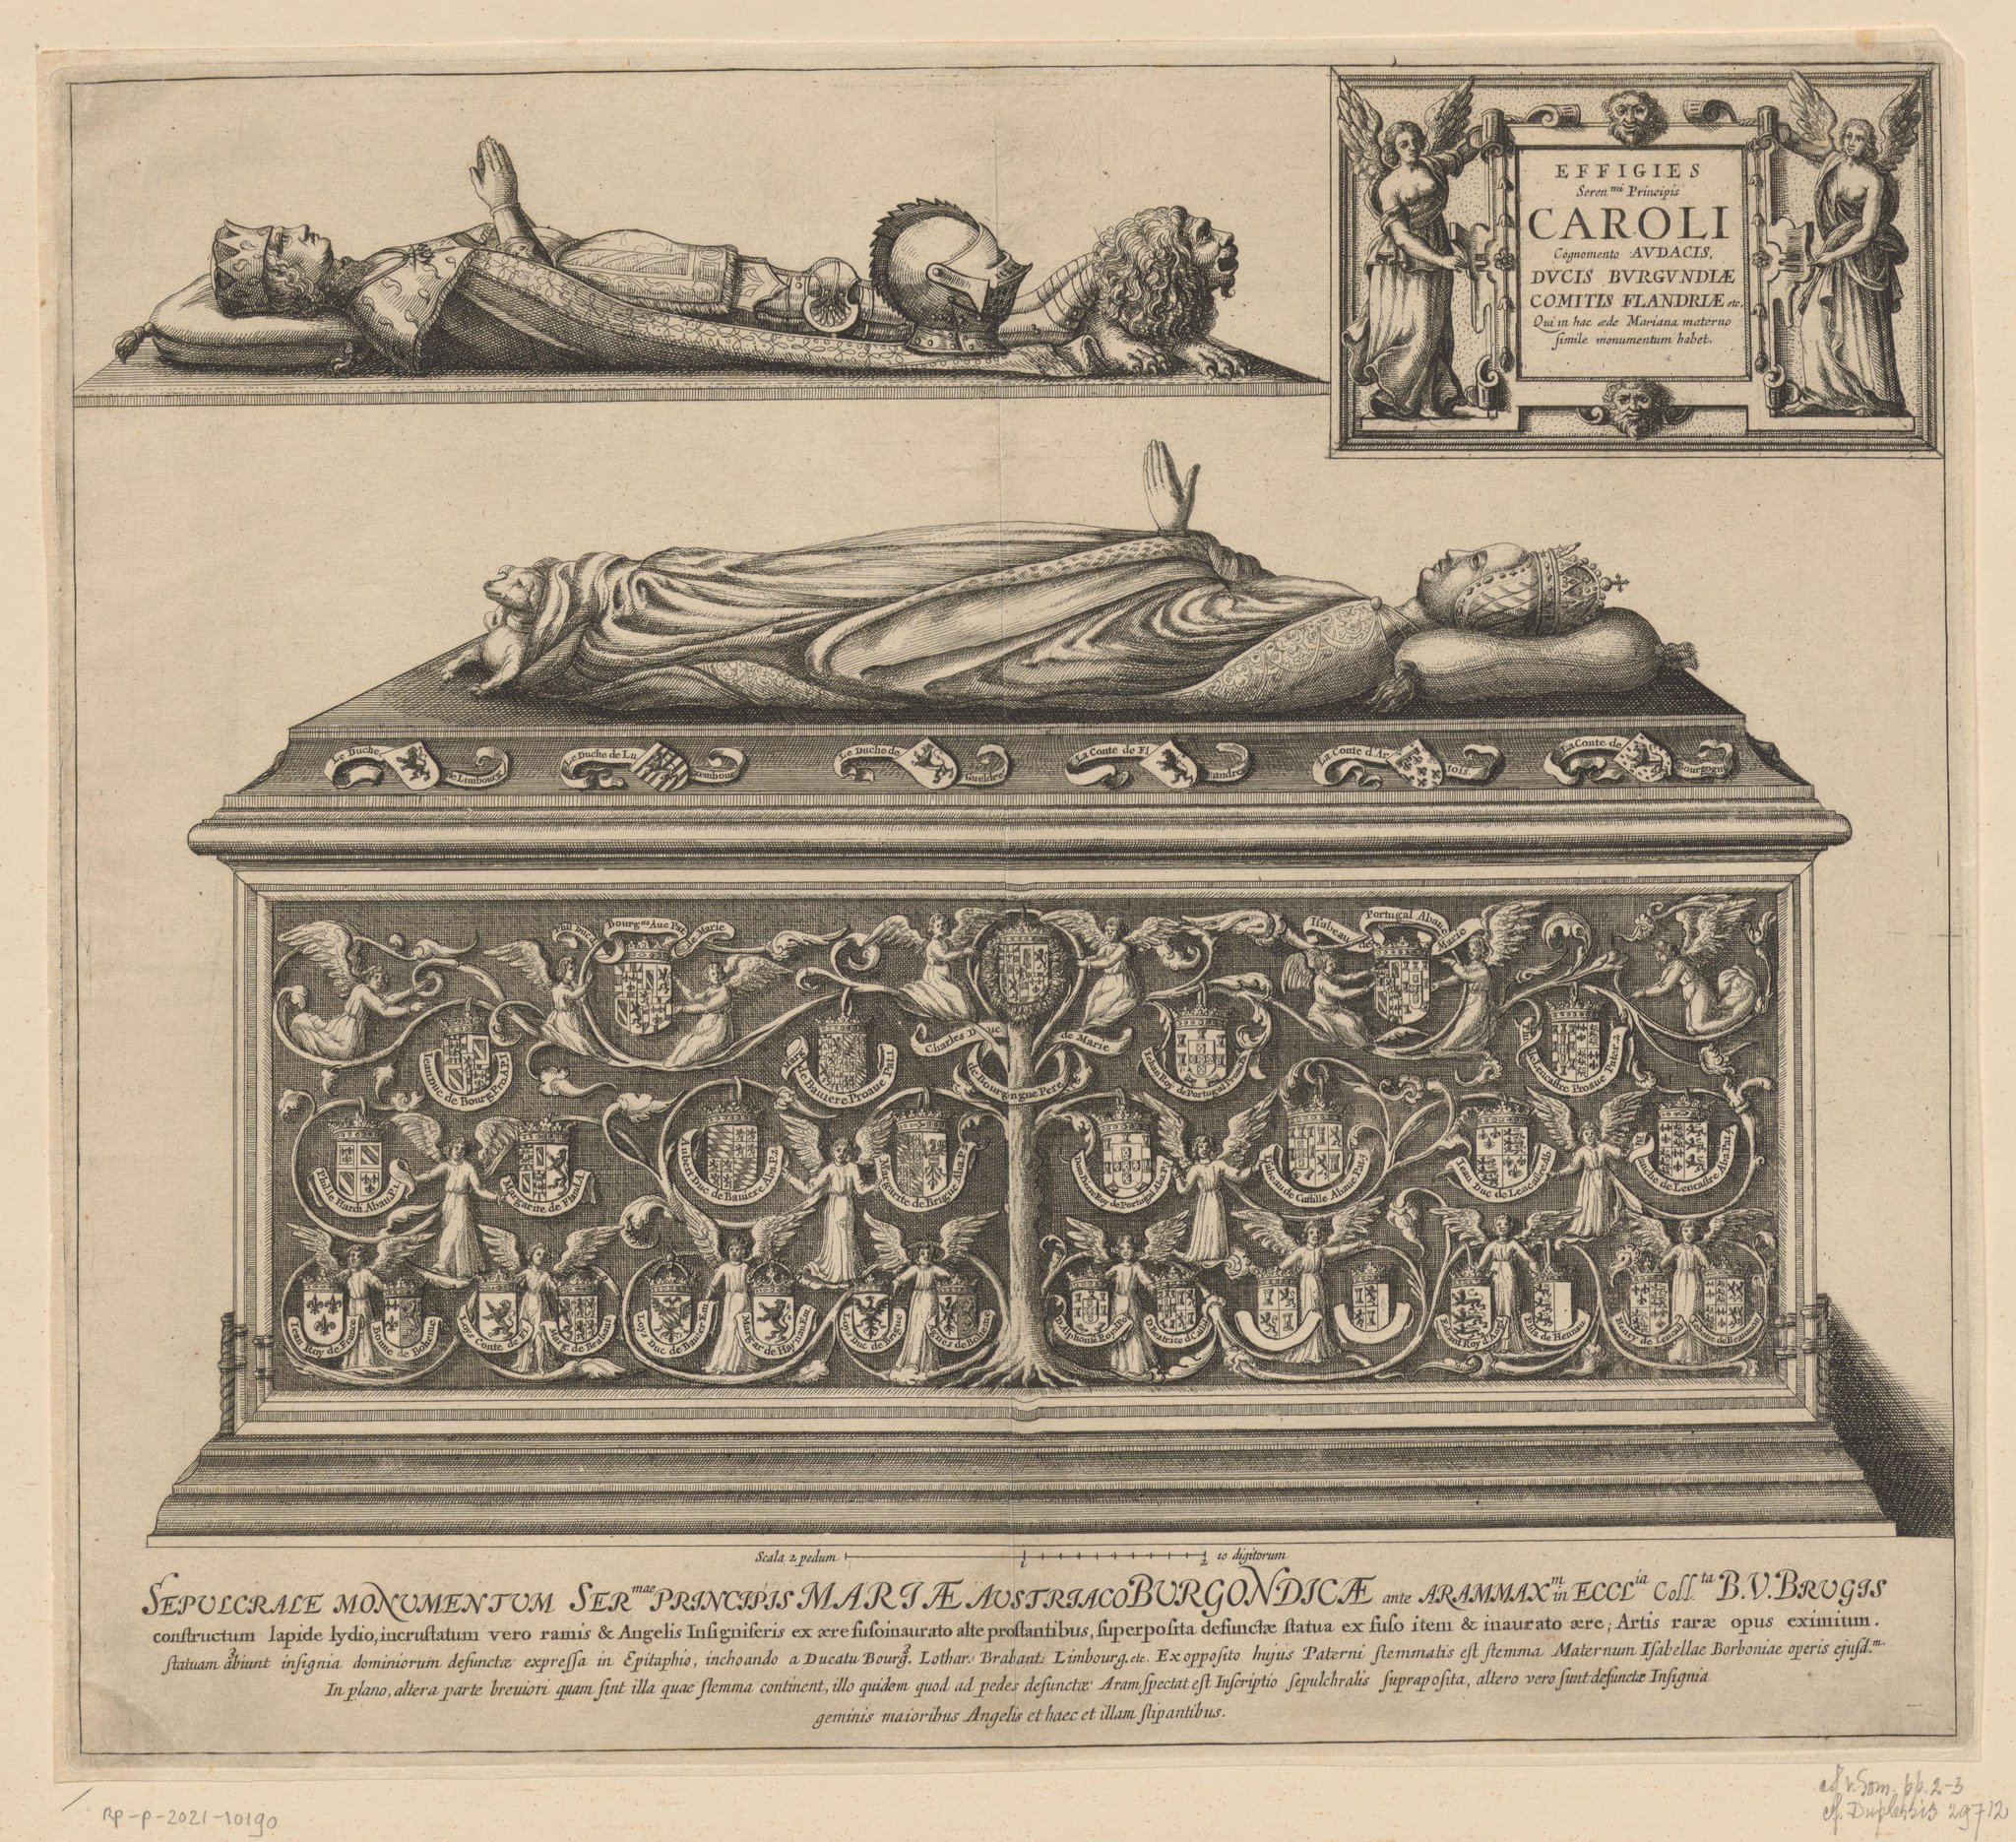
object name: print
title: Graftombe van Maria van Bourgondië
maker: Anonymous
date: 1620-1699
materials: paper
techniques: etching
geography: low countries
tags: bruges, maria (hertogin van bourgondië), earl, charles the bold (duke of burgundy), historical persons - bb - woman, historical persons, grave, tomb, armorial bearing, heraldry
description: Linksboven de graftombe van Karel de Stoute. Met vijfregelig onderschrift in het Latijn.